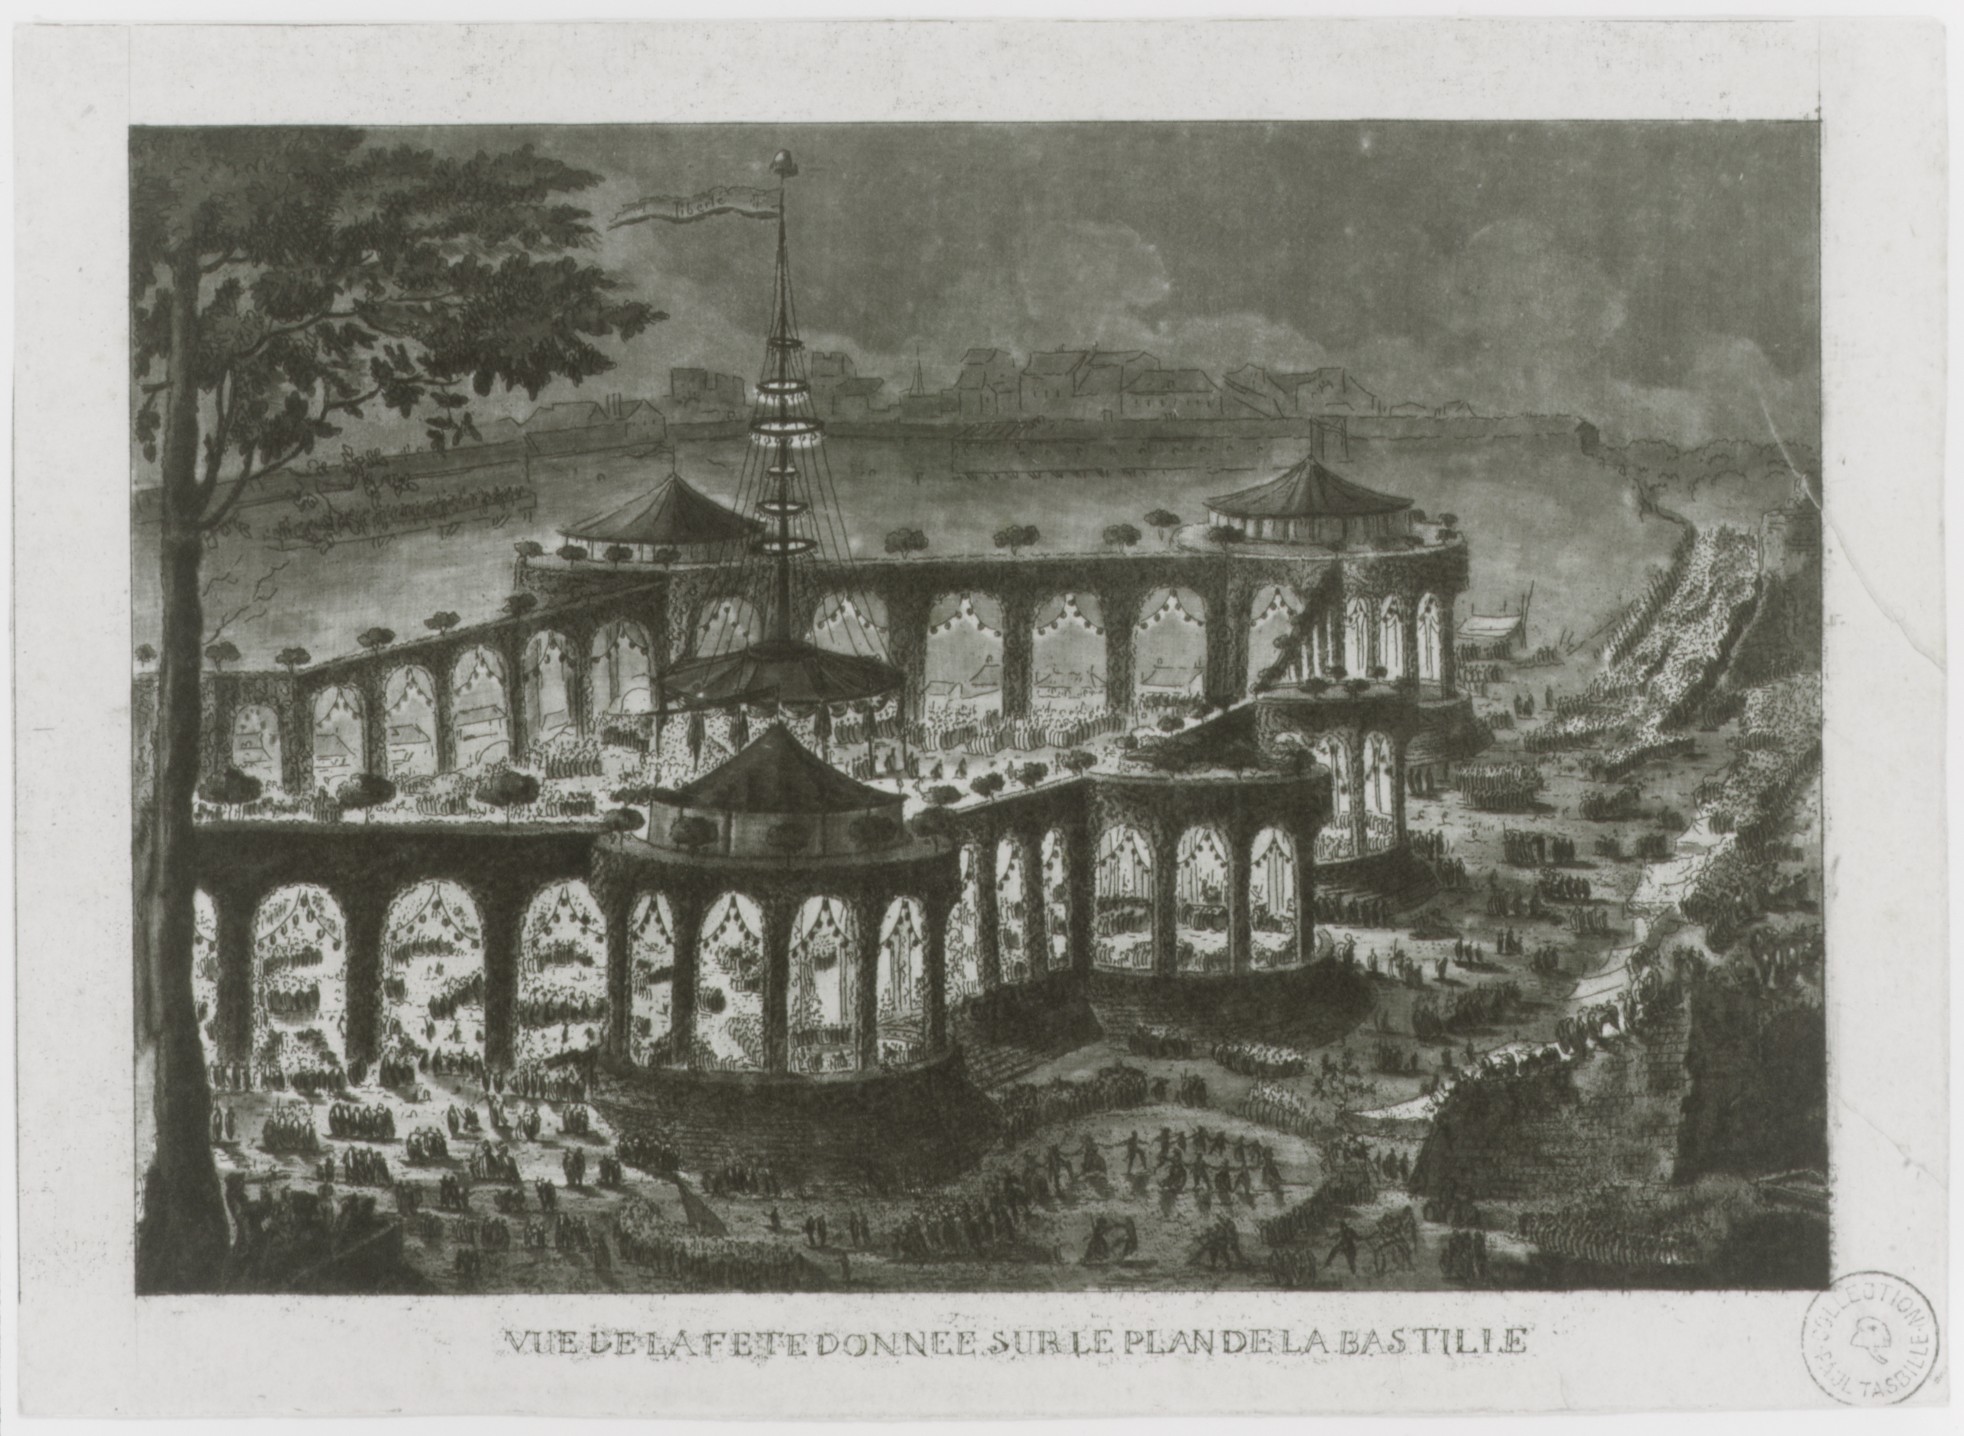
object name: print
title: Anniversary of the Fall of the Bastille, Paris, July 1790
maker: anonymous, french, 18th century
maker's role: artist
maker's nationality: french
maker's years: 1700-1800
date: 1790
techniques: aquatint, printing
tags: dancing,crowd,paris